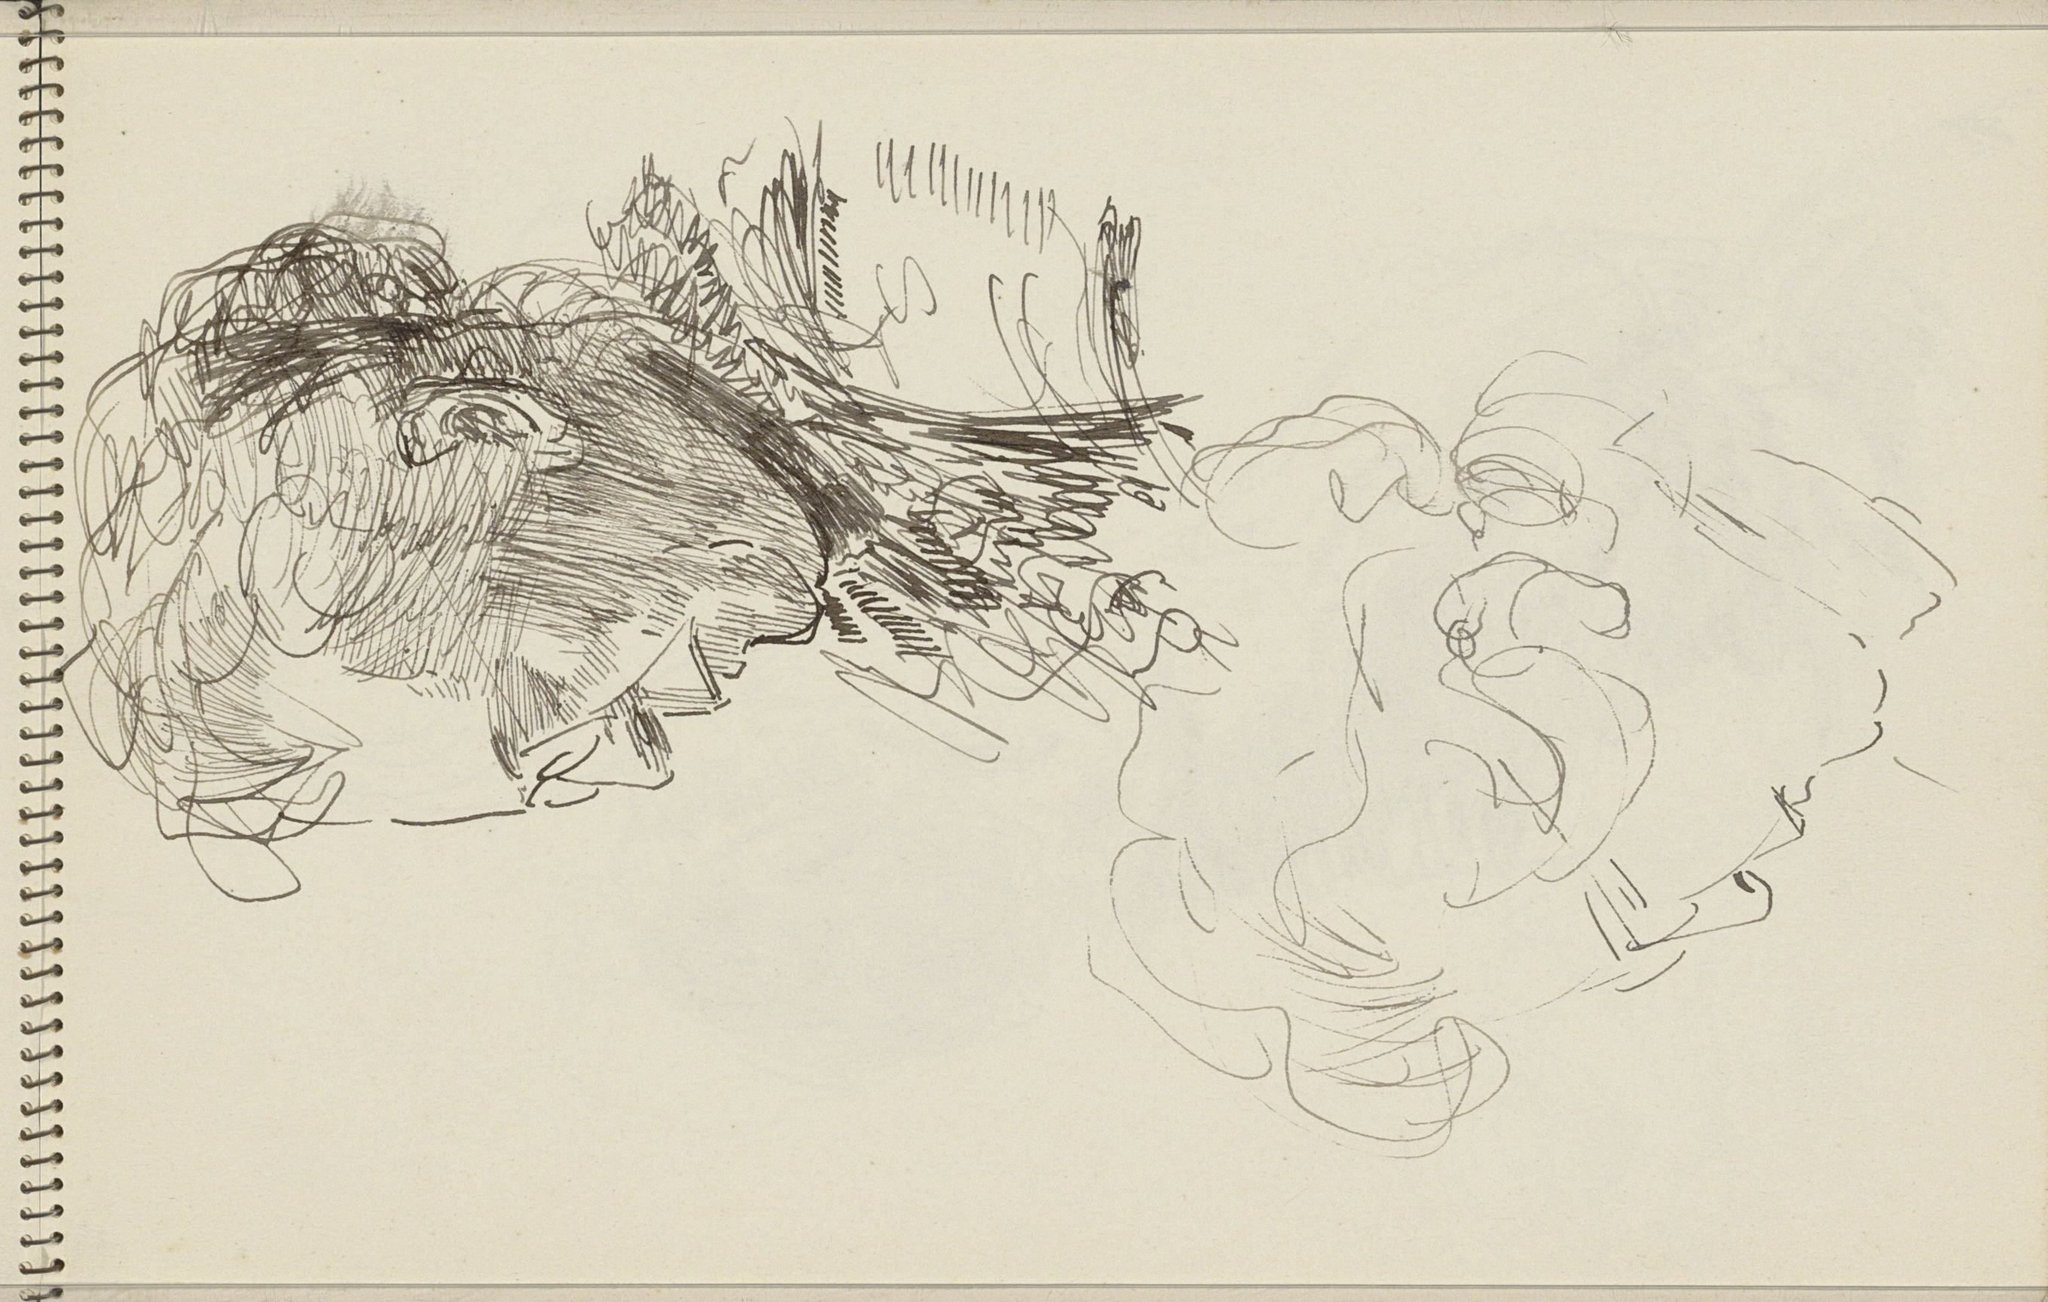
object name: sketchbook leaf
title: Portretkoppen van Joanna Lion Cachet-Cordes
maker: carel adolph lion cachet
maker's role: draughtsman, print maker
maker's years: 1864-1945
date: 1935-1940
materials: ink, paper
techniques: pen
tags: adult woman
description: Blad 4 recto uit een schetsboek met 25 bladen.